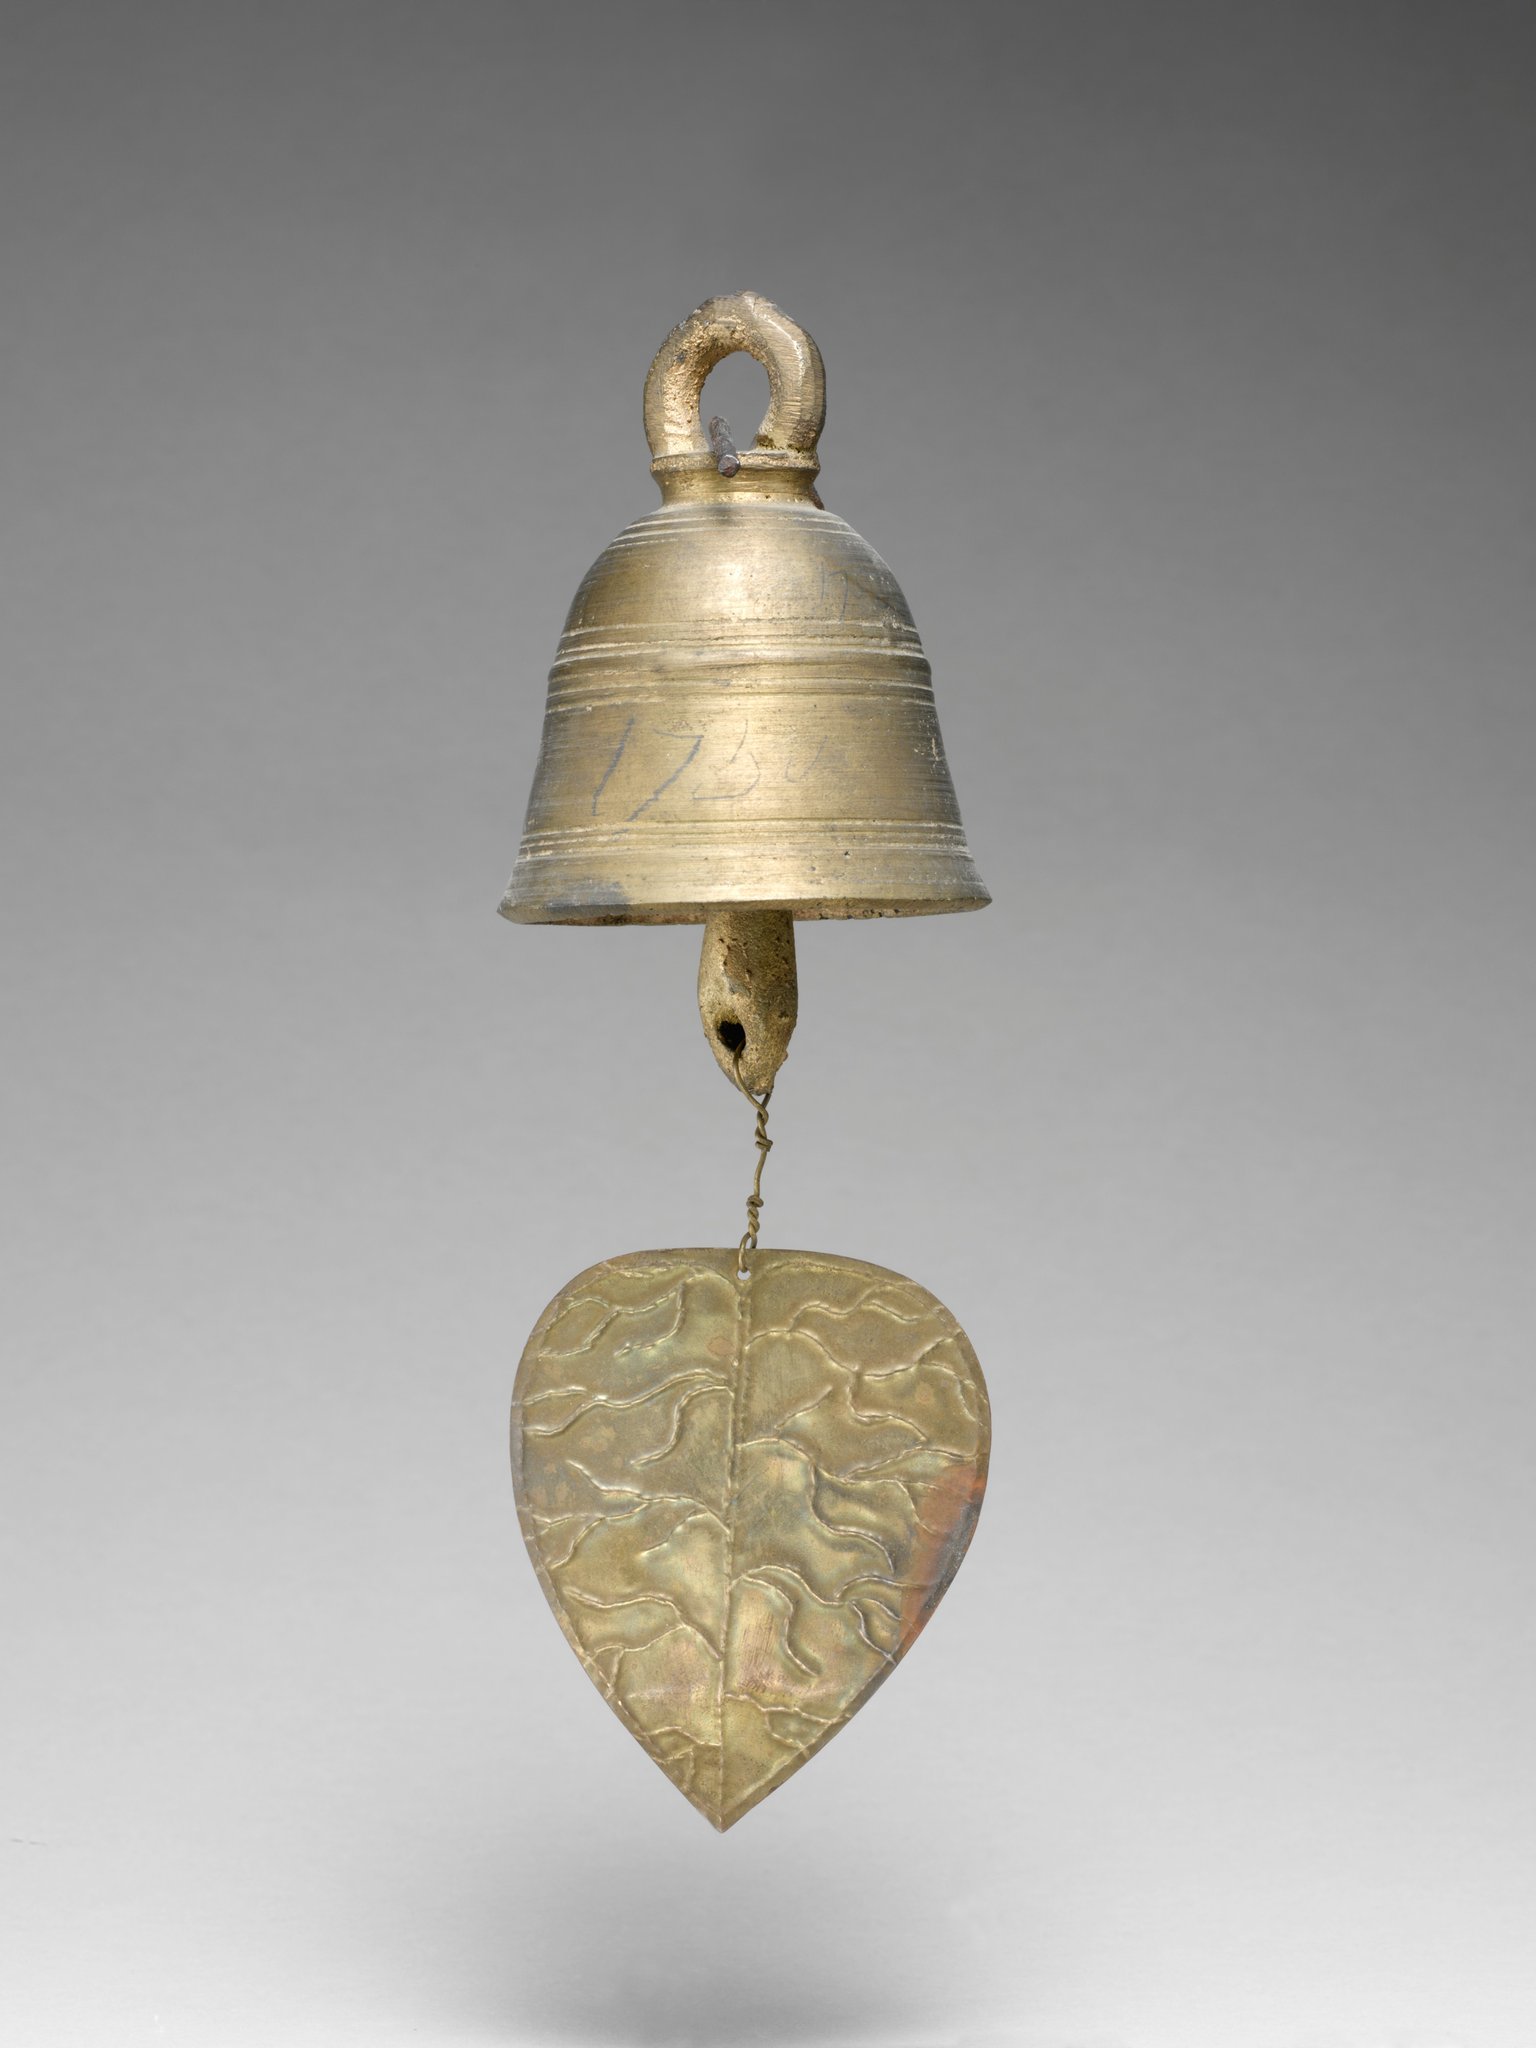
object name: khew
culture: burmese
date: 1867-1900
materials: metal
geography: myanmar